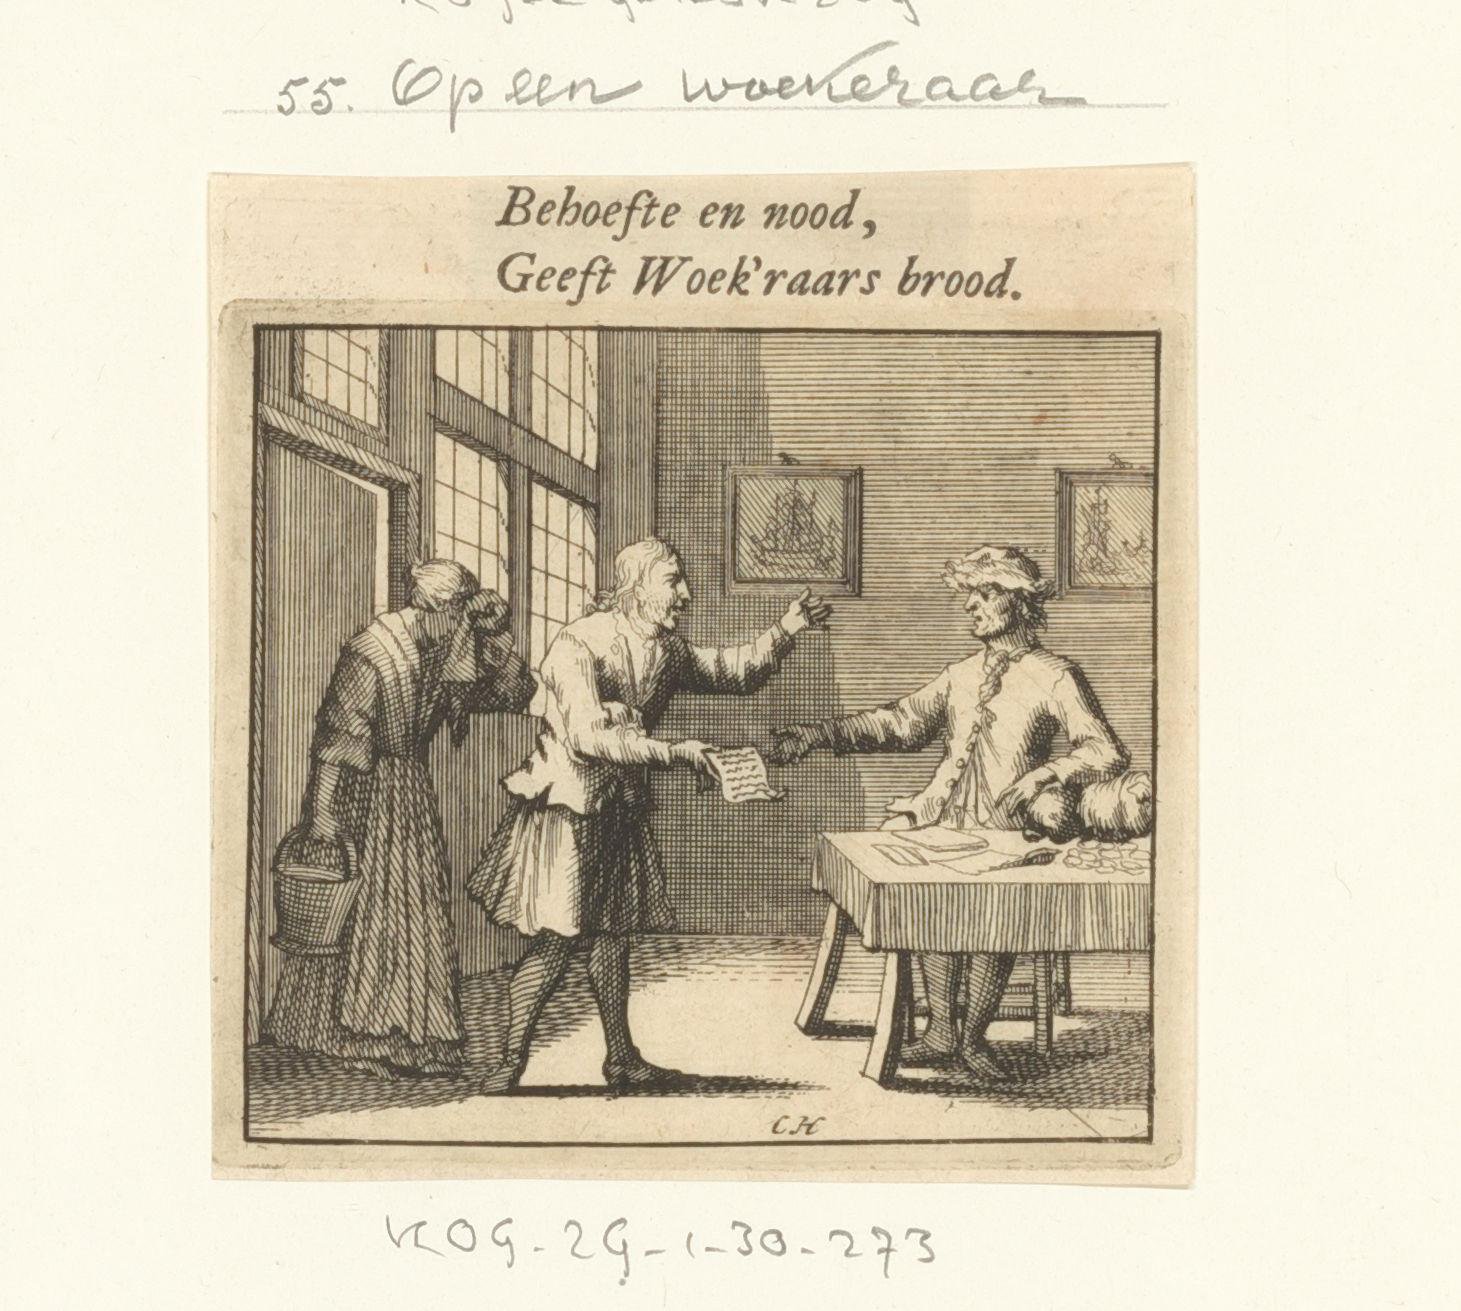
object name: print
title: Behoefte en nood, Geeft Woek'raars brood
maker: cornelis huyberts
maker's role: print maker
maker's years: 1669-1709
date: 1725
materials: paper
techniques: etching, letterpress printing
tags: money-lender, usurer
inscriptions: collector's mark: Lugt 1641, stamp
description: Prent uit: Graauwhart, Hendrik. Voorbeeldelyke zeede-lessen, genoomen uyt den eersten toestand des werelds (...). Amsterdam: Johannes Ratelband, 1725. Prent ook gebruikt voor eerdere en (1709) latere uitgave (1756, 1761 en 1764).